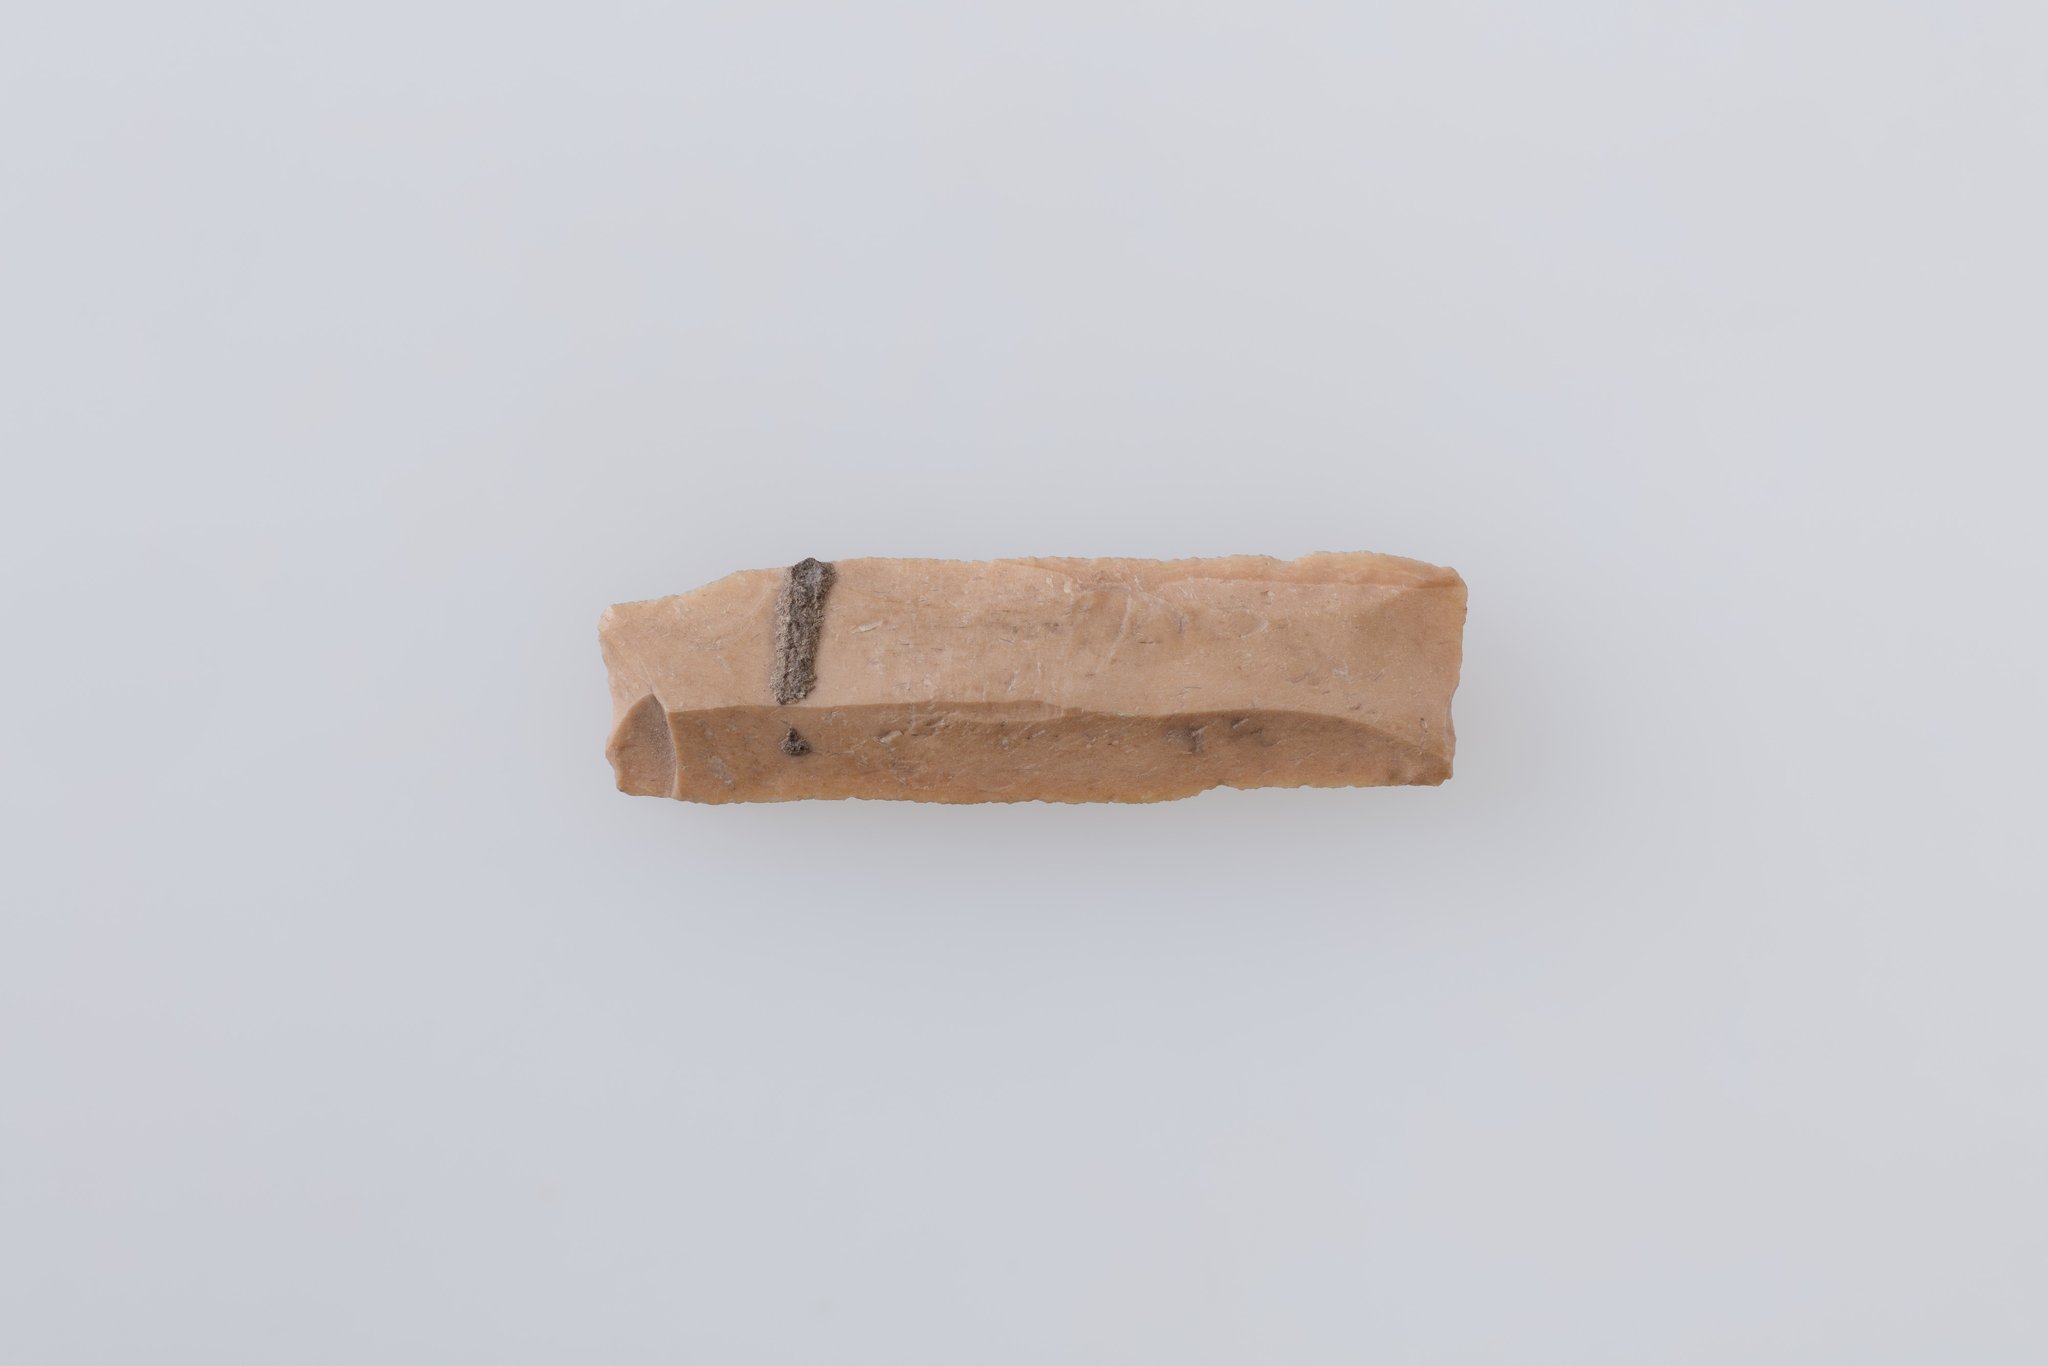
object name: tool, blade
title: Tool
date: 3100-2649 BCE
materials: stone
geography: egypt